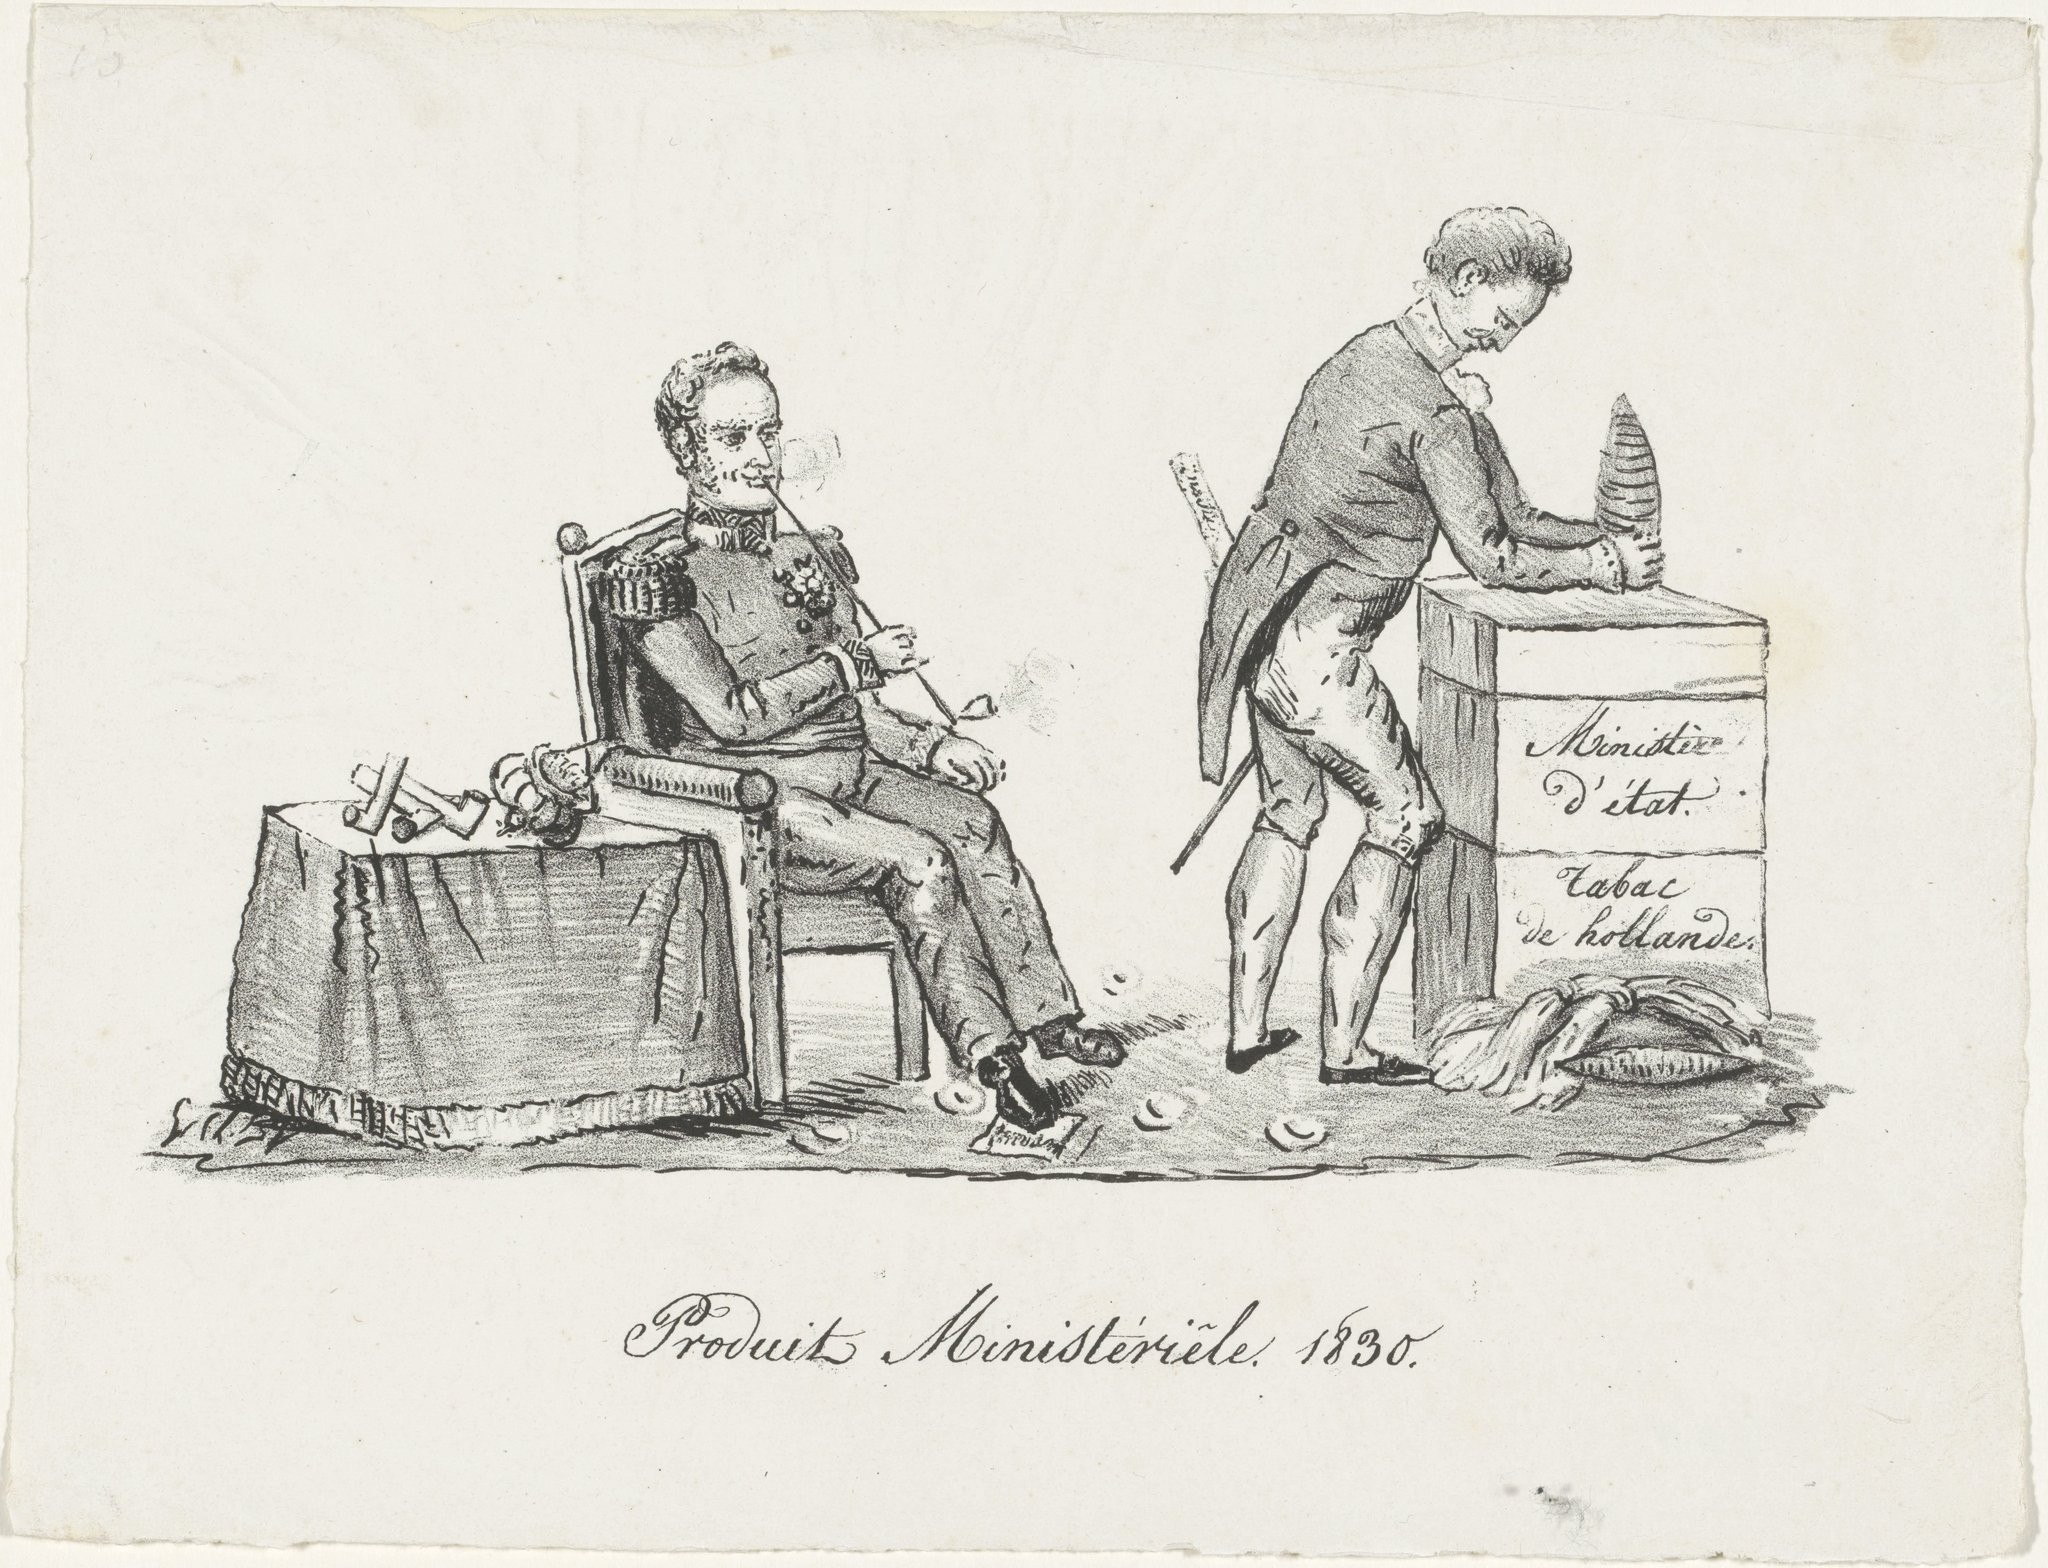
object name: cartoon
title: Koning Willlem I aan de tabak, 1830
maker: Anonymous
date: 1830-1831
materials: paper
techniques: lithograph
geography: belgium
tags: berlin, william i of the netherlands, tobacco-roll, coiled twist of tobacco, pipe ~ tobacco, snuff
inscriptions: collector's mark: Lugt 2228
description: Spotprent op koning Willem I, die zittend op de troon een pijp rookt, op de tafel links ligt zijn kroon en een aantal kachelpijpen, ca. 1830. Rechts zet een minister, mogelijk Cornelis Felix van Maanen, een snuif carotte op een stapel dozen Hollandse tabak.